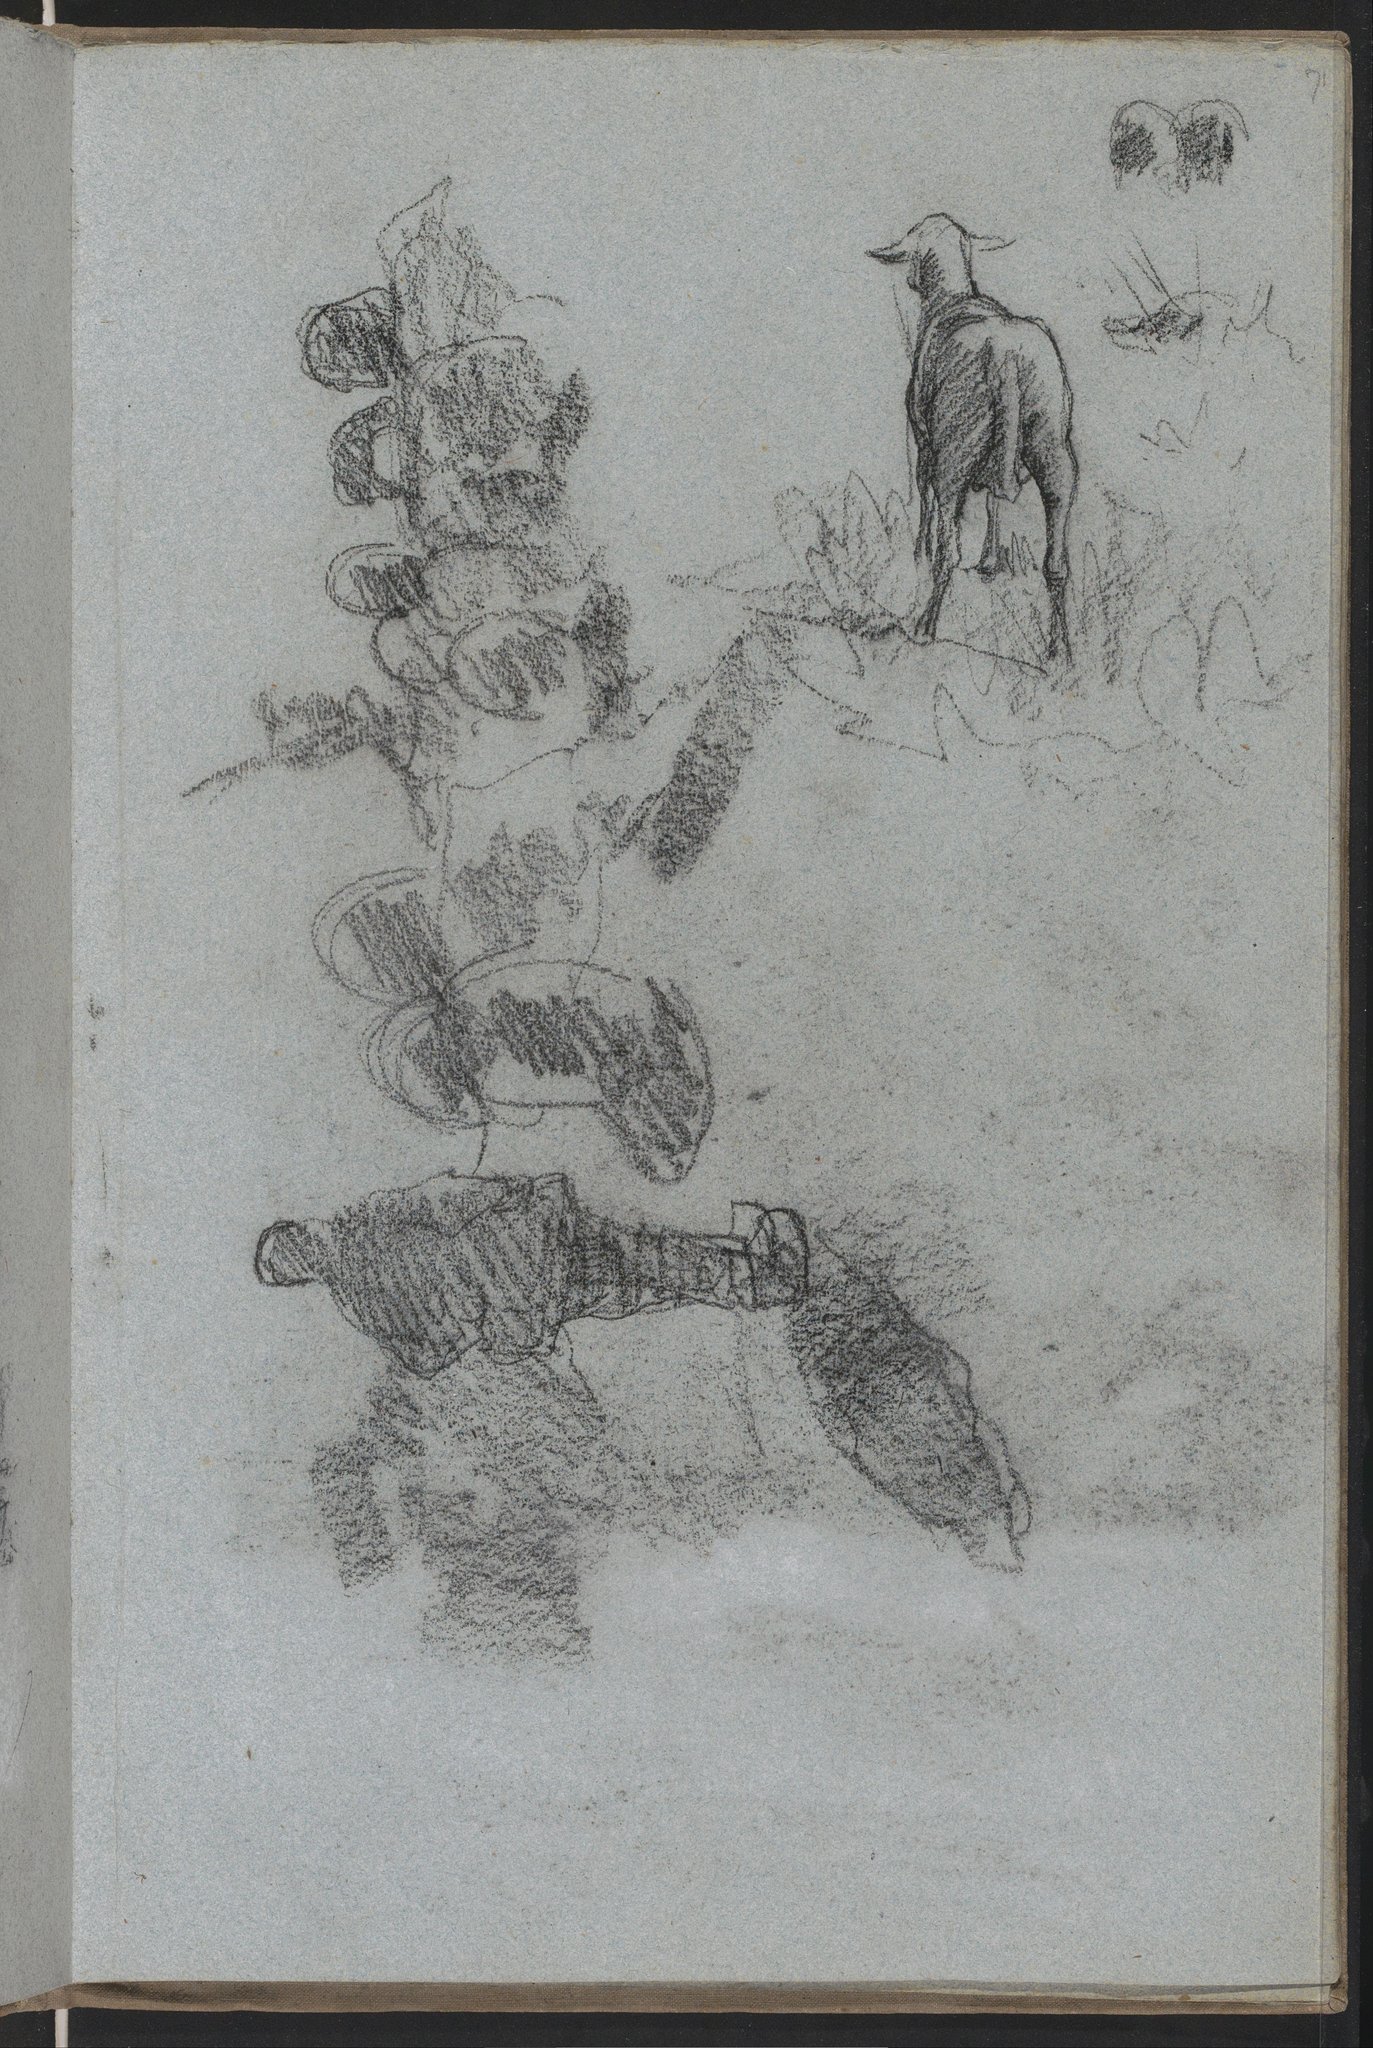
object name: sketchbook leaf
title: Schaapherder bij zijn kudde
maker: willem witsen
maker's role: draughtsman, painter, print maker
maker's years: 1860-1923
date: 1884-1887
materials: chalk, paper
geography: ewijkshoeve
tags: landscapes in the temperate zone, cattle driving, cattle driver, sheep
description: Verder studies van schapen. Pagina 71 uit een schetsboek met 45 bladen vervaardigd rond de Ewijkshoeve.